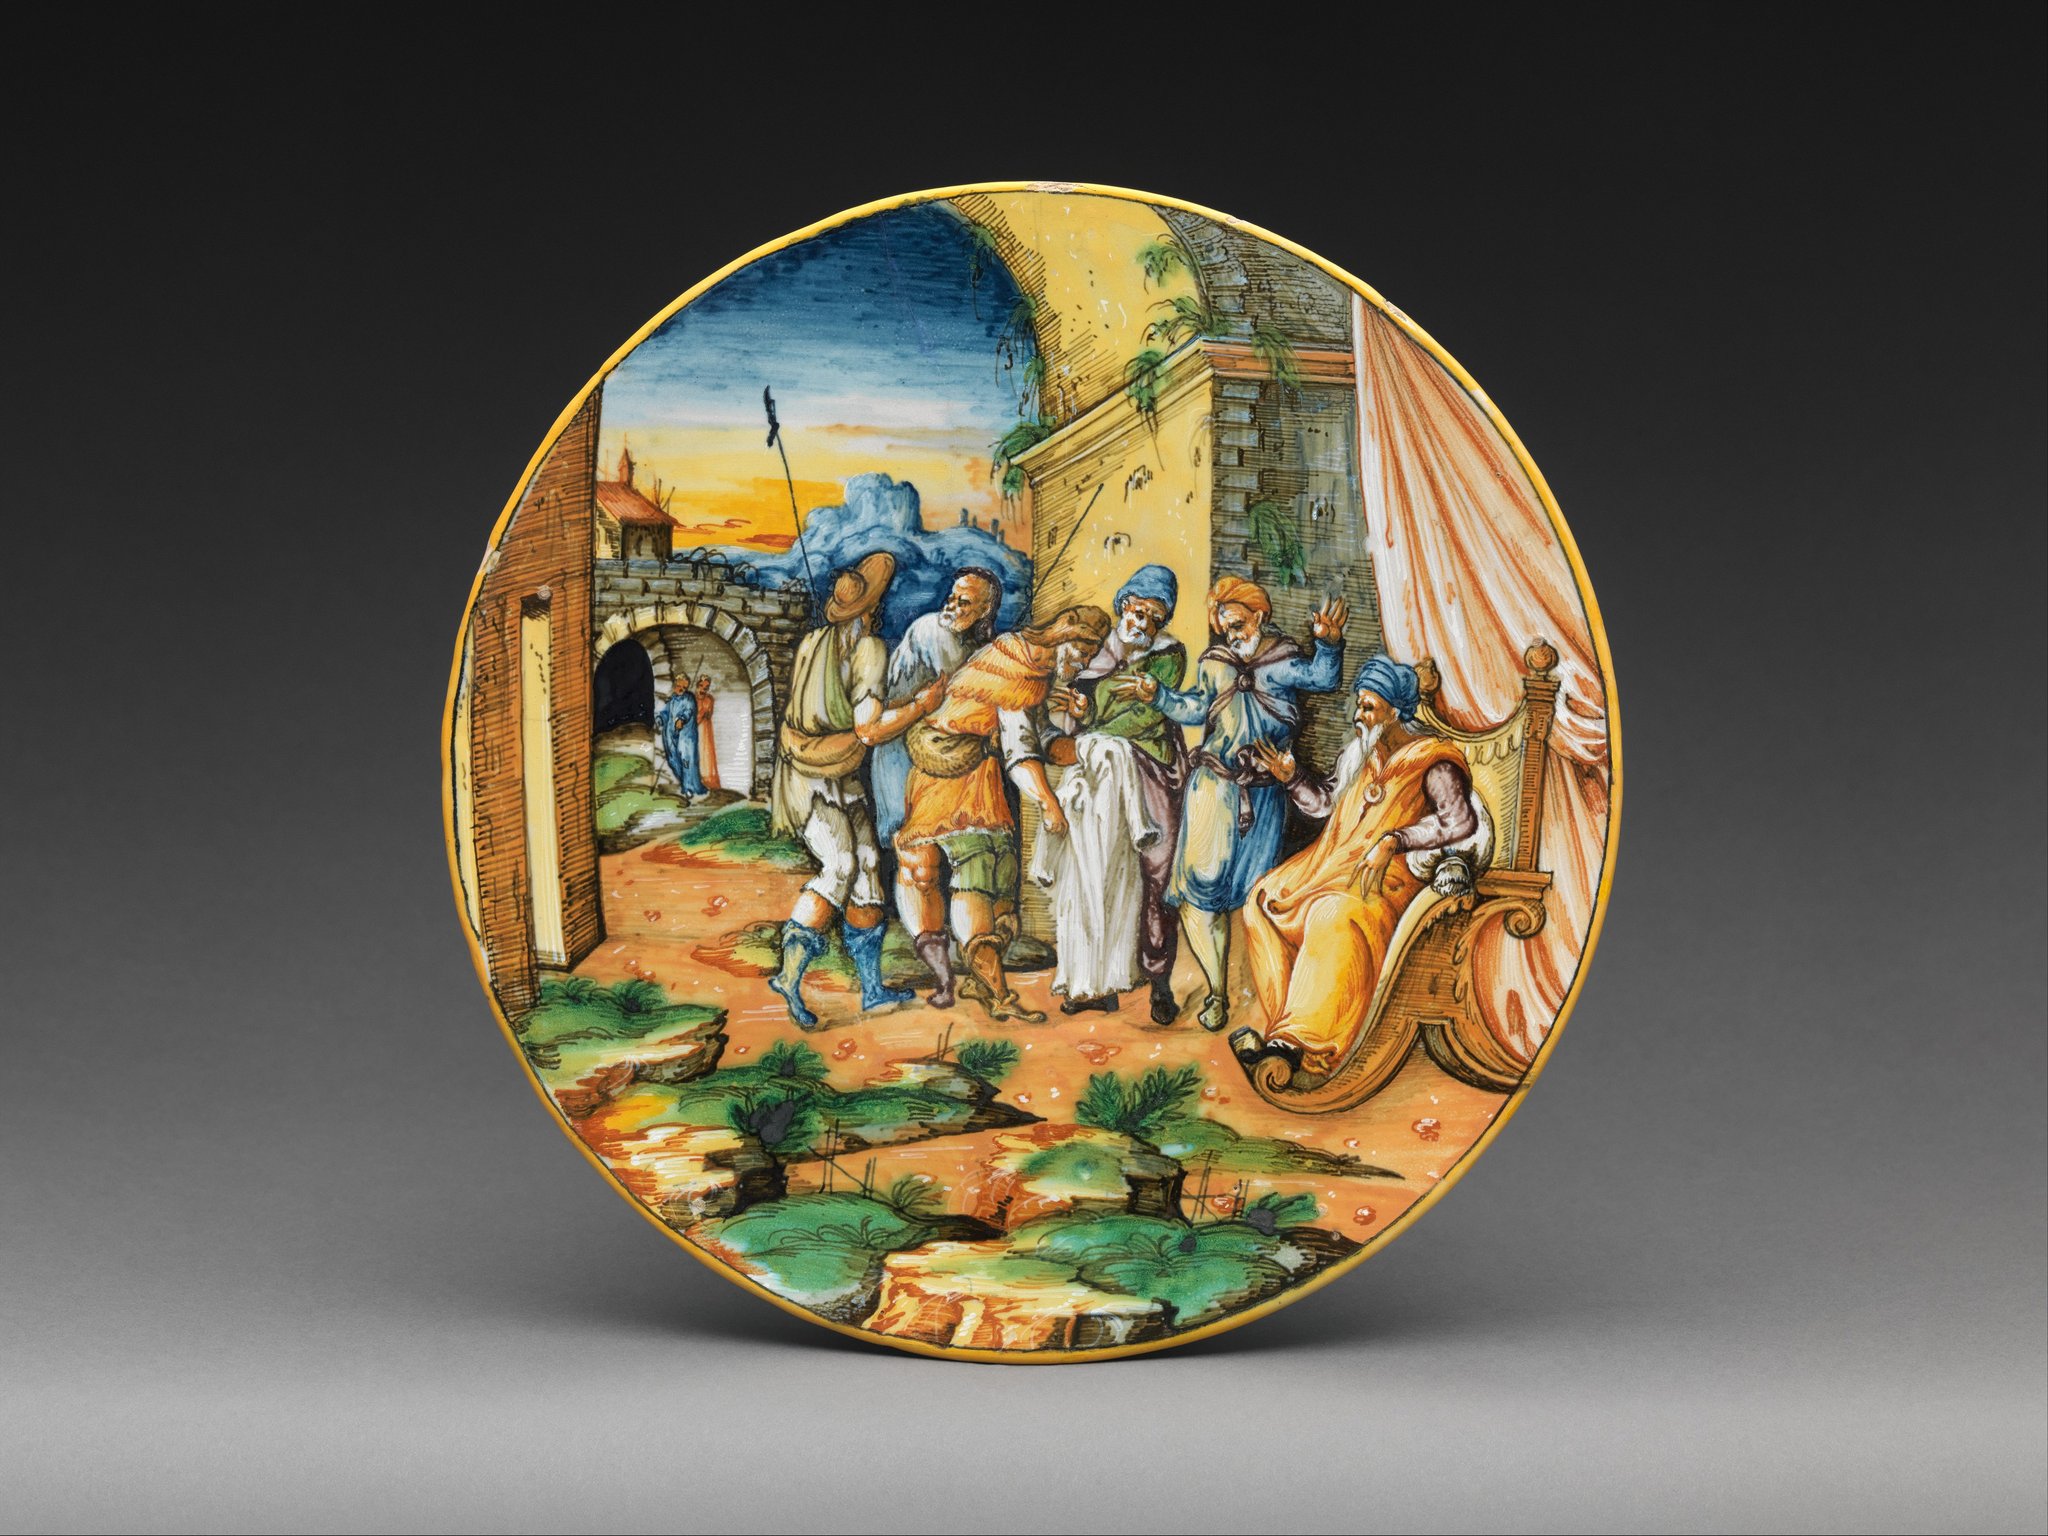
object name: plate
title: Plate with Jacob Is Shown Joseph’s Coat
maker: gironimo tomasi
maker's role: artist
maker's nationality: italian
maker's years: 1502-1602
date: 1560-1575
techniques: maiolica, glazing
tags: men